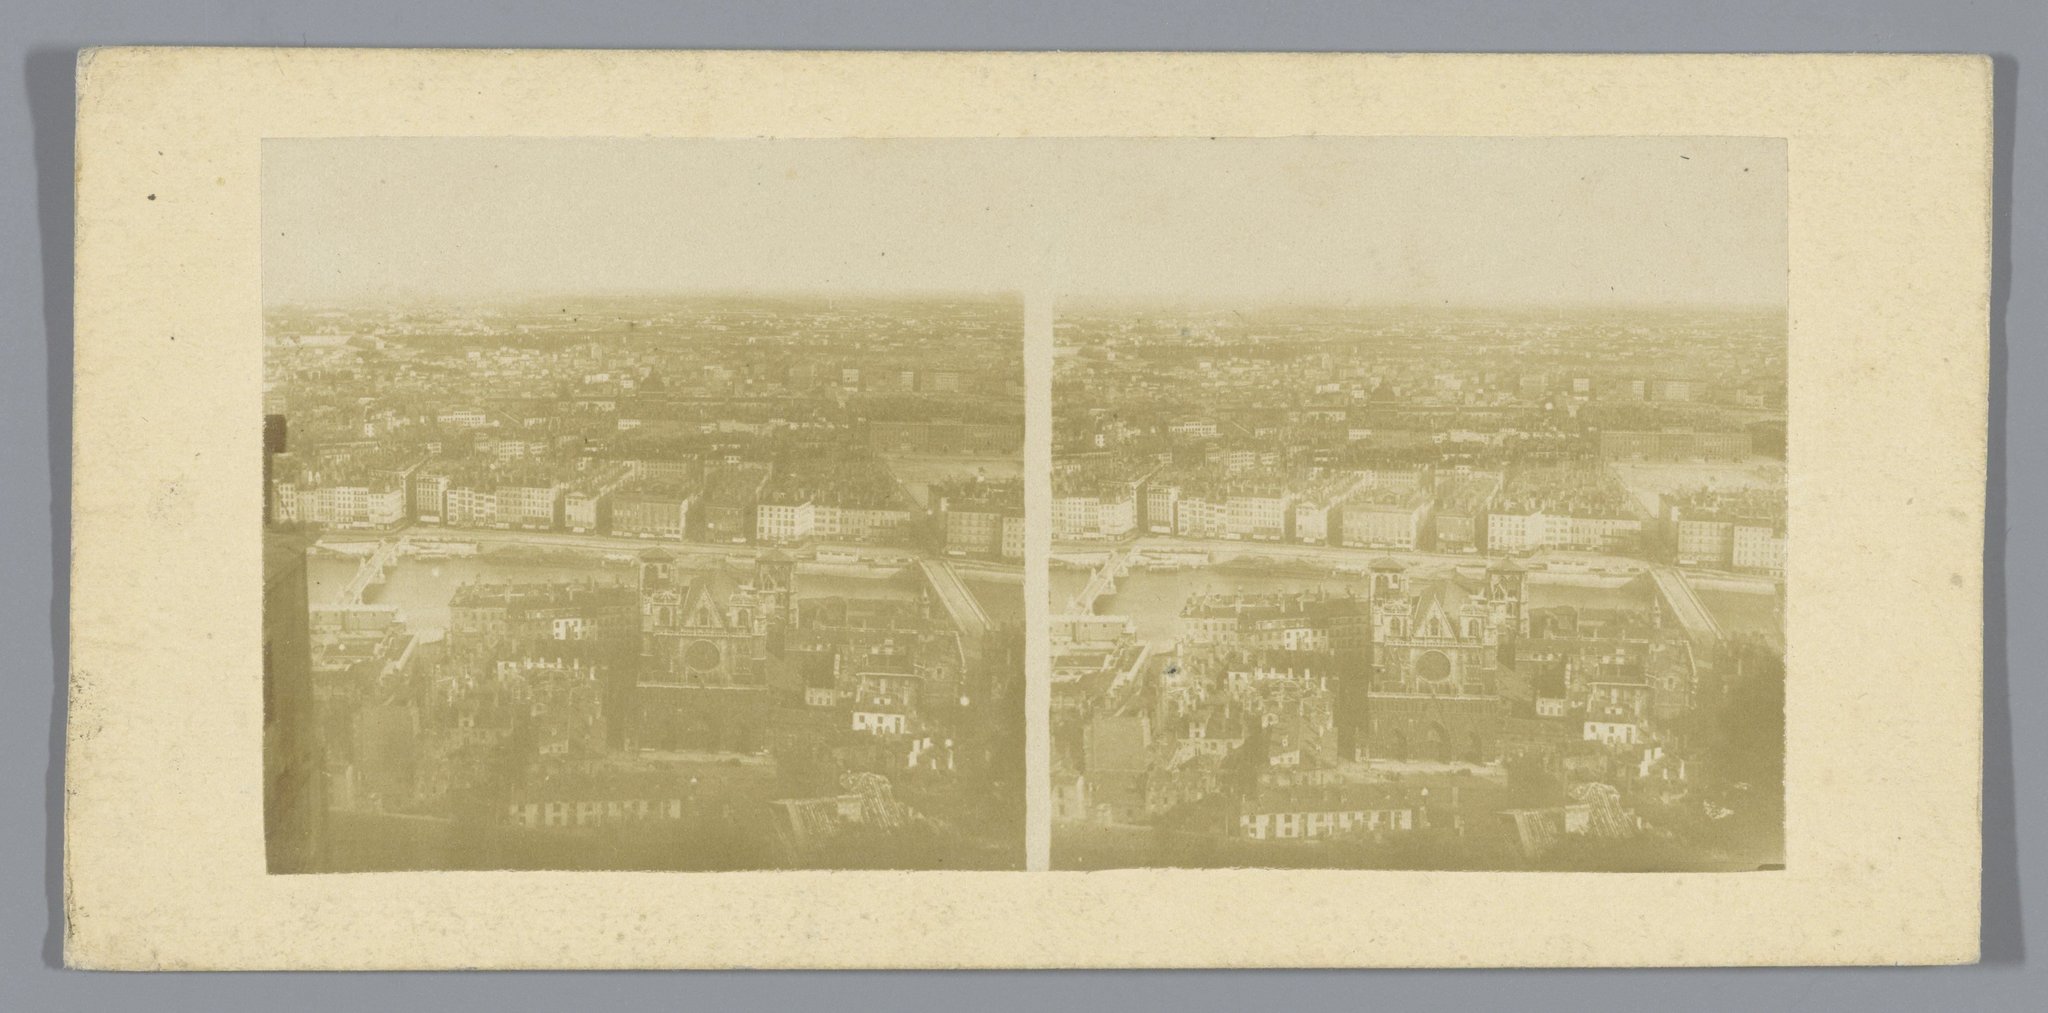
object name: stereograph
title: Gezicht op Lyon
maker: Anonymous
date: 1850-1870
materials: cardboard, photographic support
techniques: albumen print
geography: lyon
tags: lyon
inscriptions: inscription: ‘Lyon à vol d'oiseau’, inscription: ‘168, Rue de Rivoli Gd hôtel du Louvre Ledot Jne Editeur Estampes Photographies Plans et Guides pour Voyageurs et vues pr. Stéréoscope’